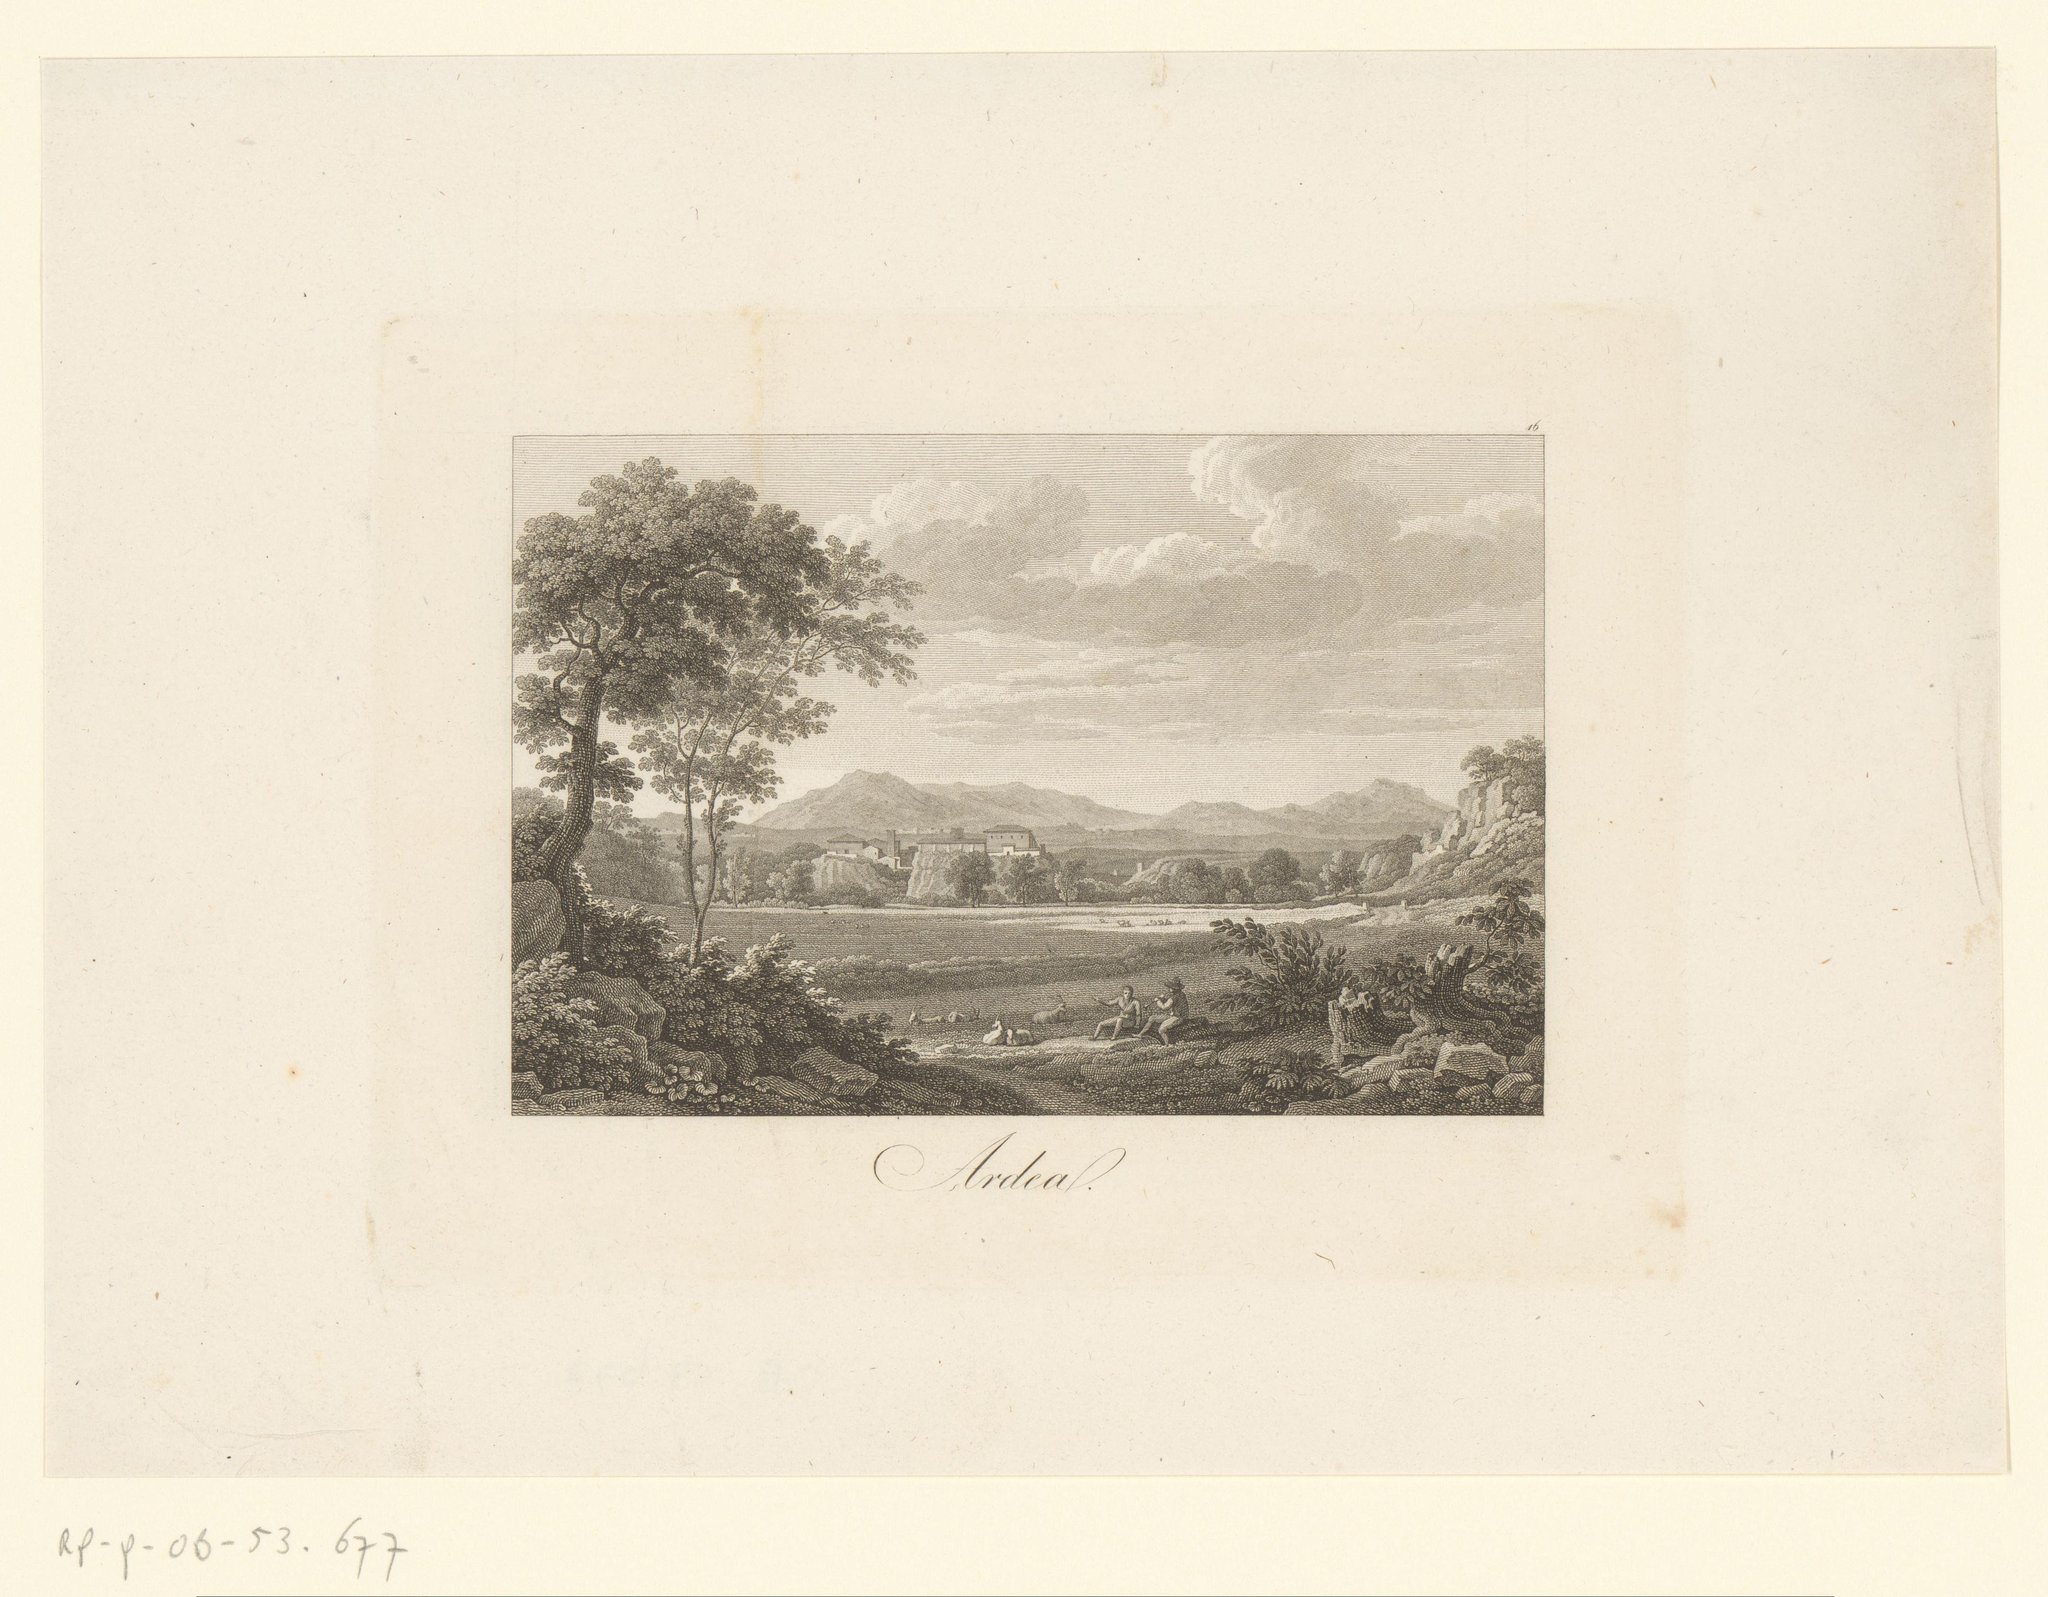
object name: print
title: Ardea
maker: johann christian reinhart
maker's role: print maker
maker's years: 1761-1847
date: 1771-1847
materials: paper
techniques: engraving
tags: landscapes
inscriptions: collector's mark: Lugt 2228